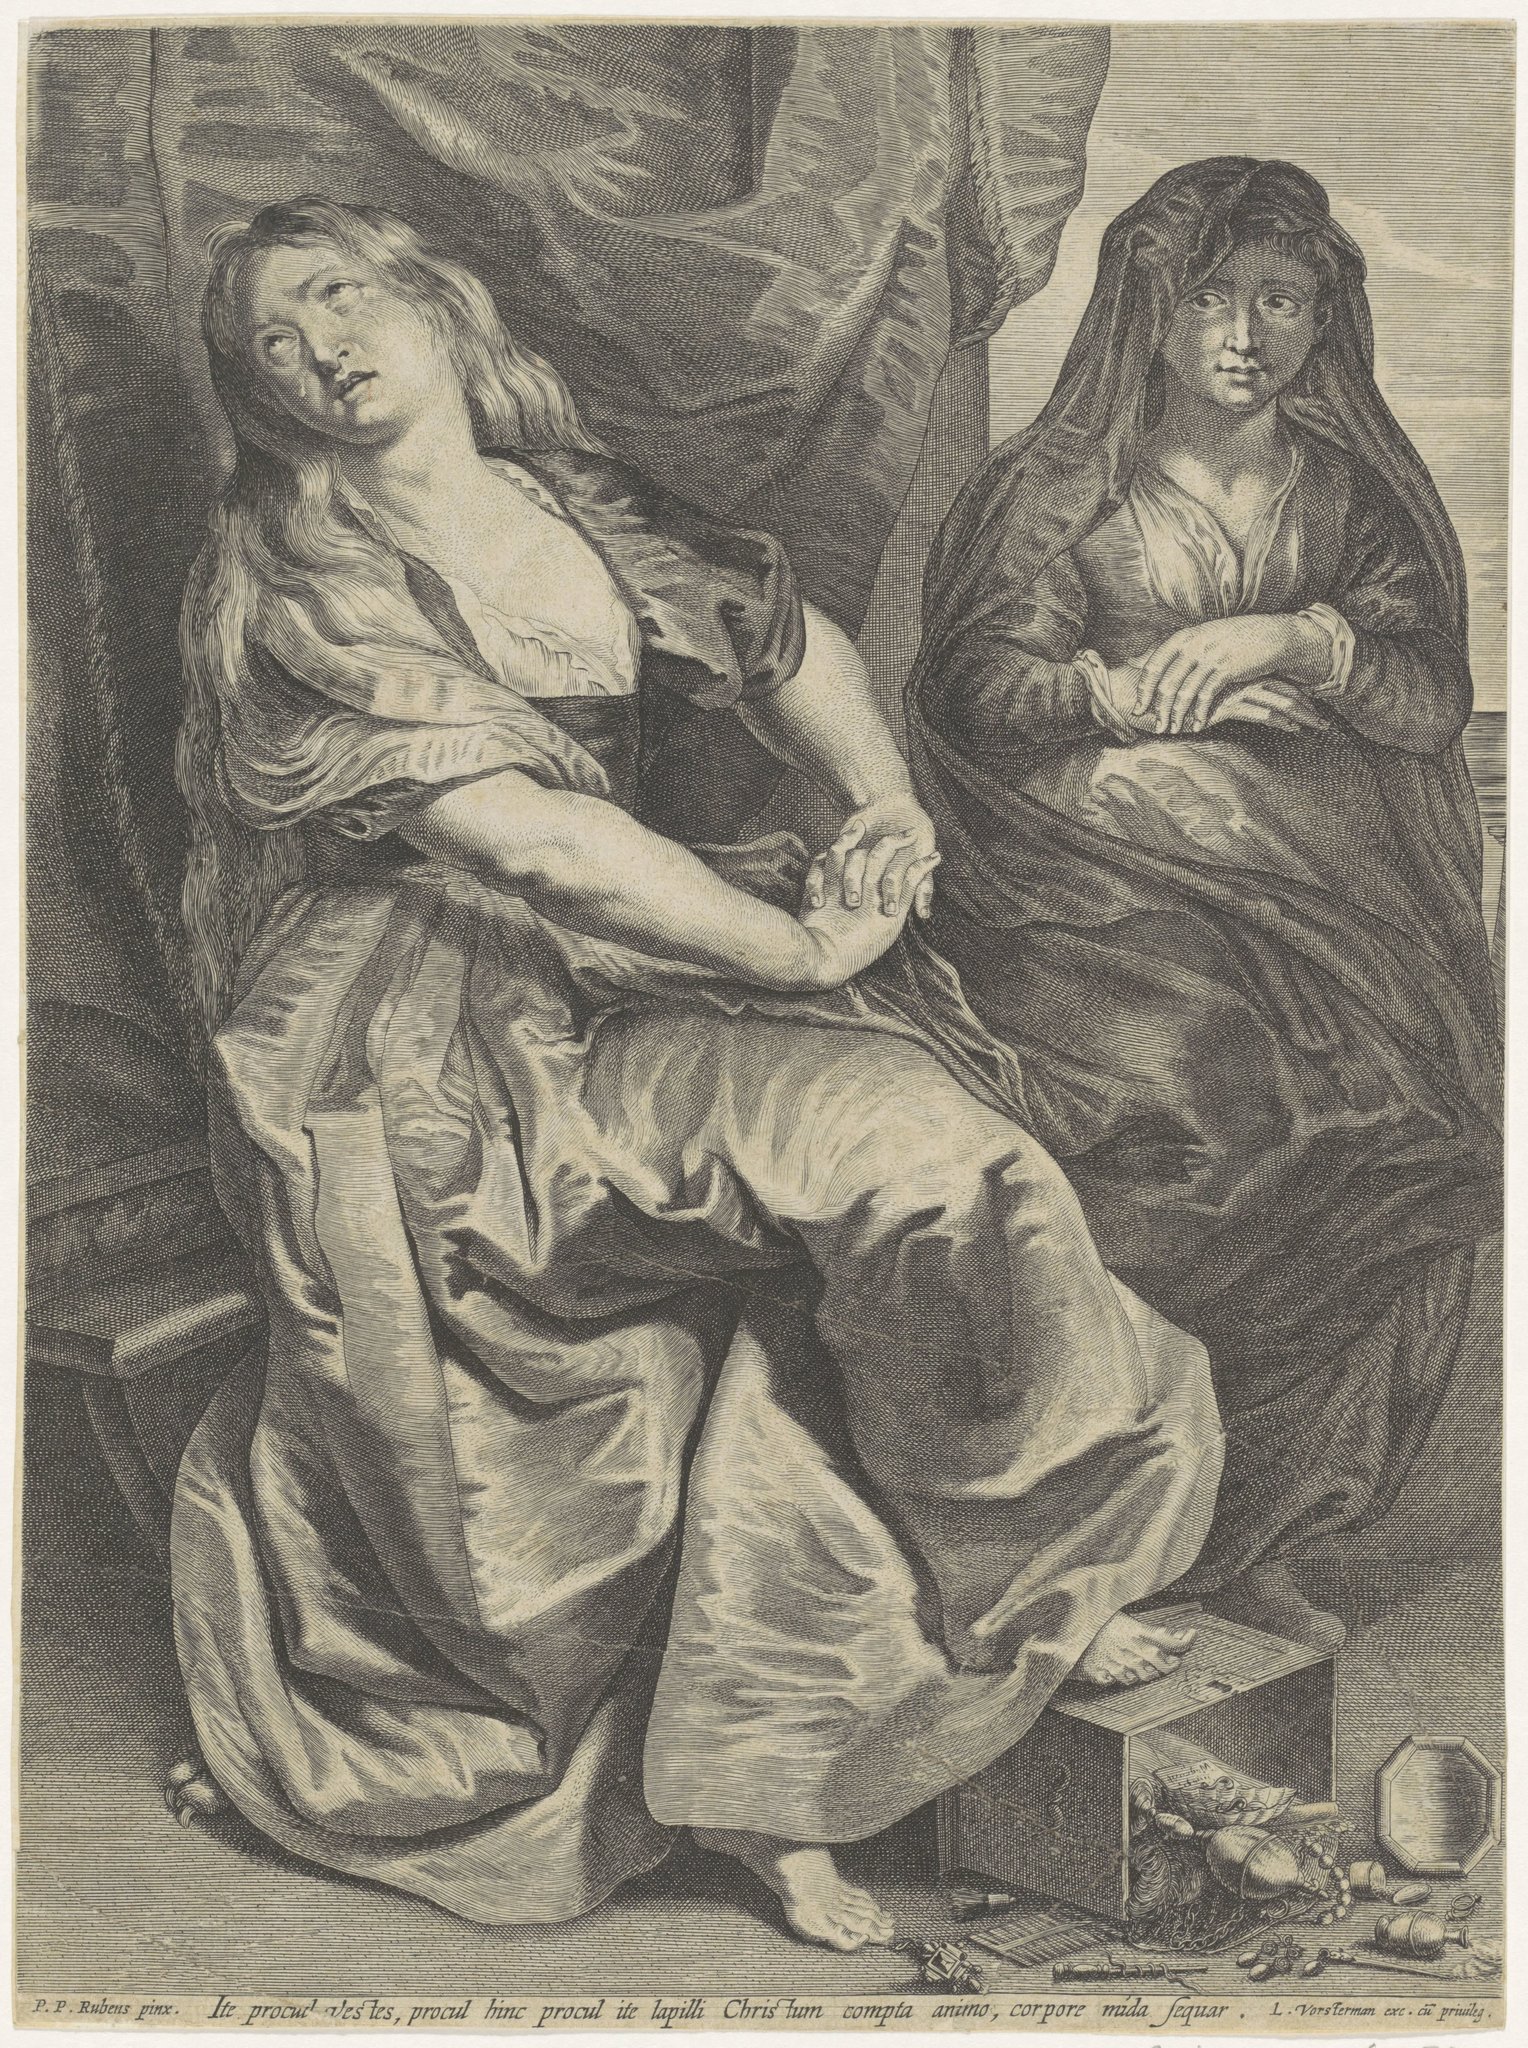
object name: print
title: Maria Magdalena doet afstand van aardse ijdelheden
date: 1619-1675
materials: paper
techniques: engraving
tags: st. mary magdalene renounces the vanities of the world, laying aside her jewels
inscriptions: collector's mark: Lugt 10, collector's mark: Lugt 11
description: Maria Magdalena vertrapt een kist met haar aardse bezittingen, waaronder een spiegel, parfumflesje, haarspelden en sieraden.